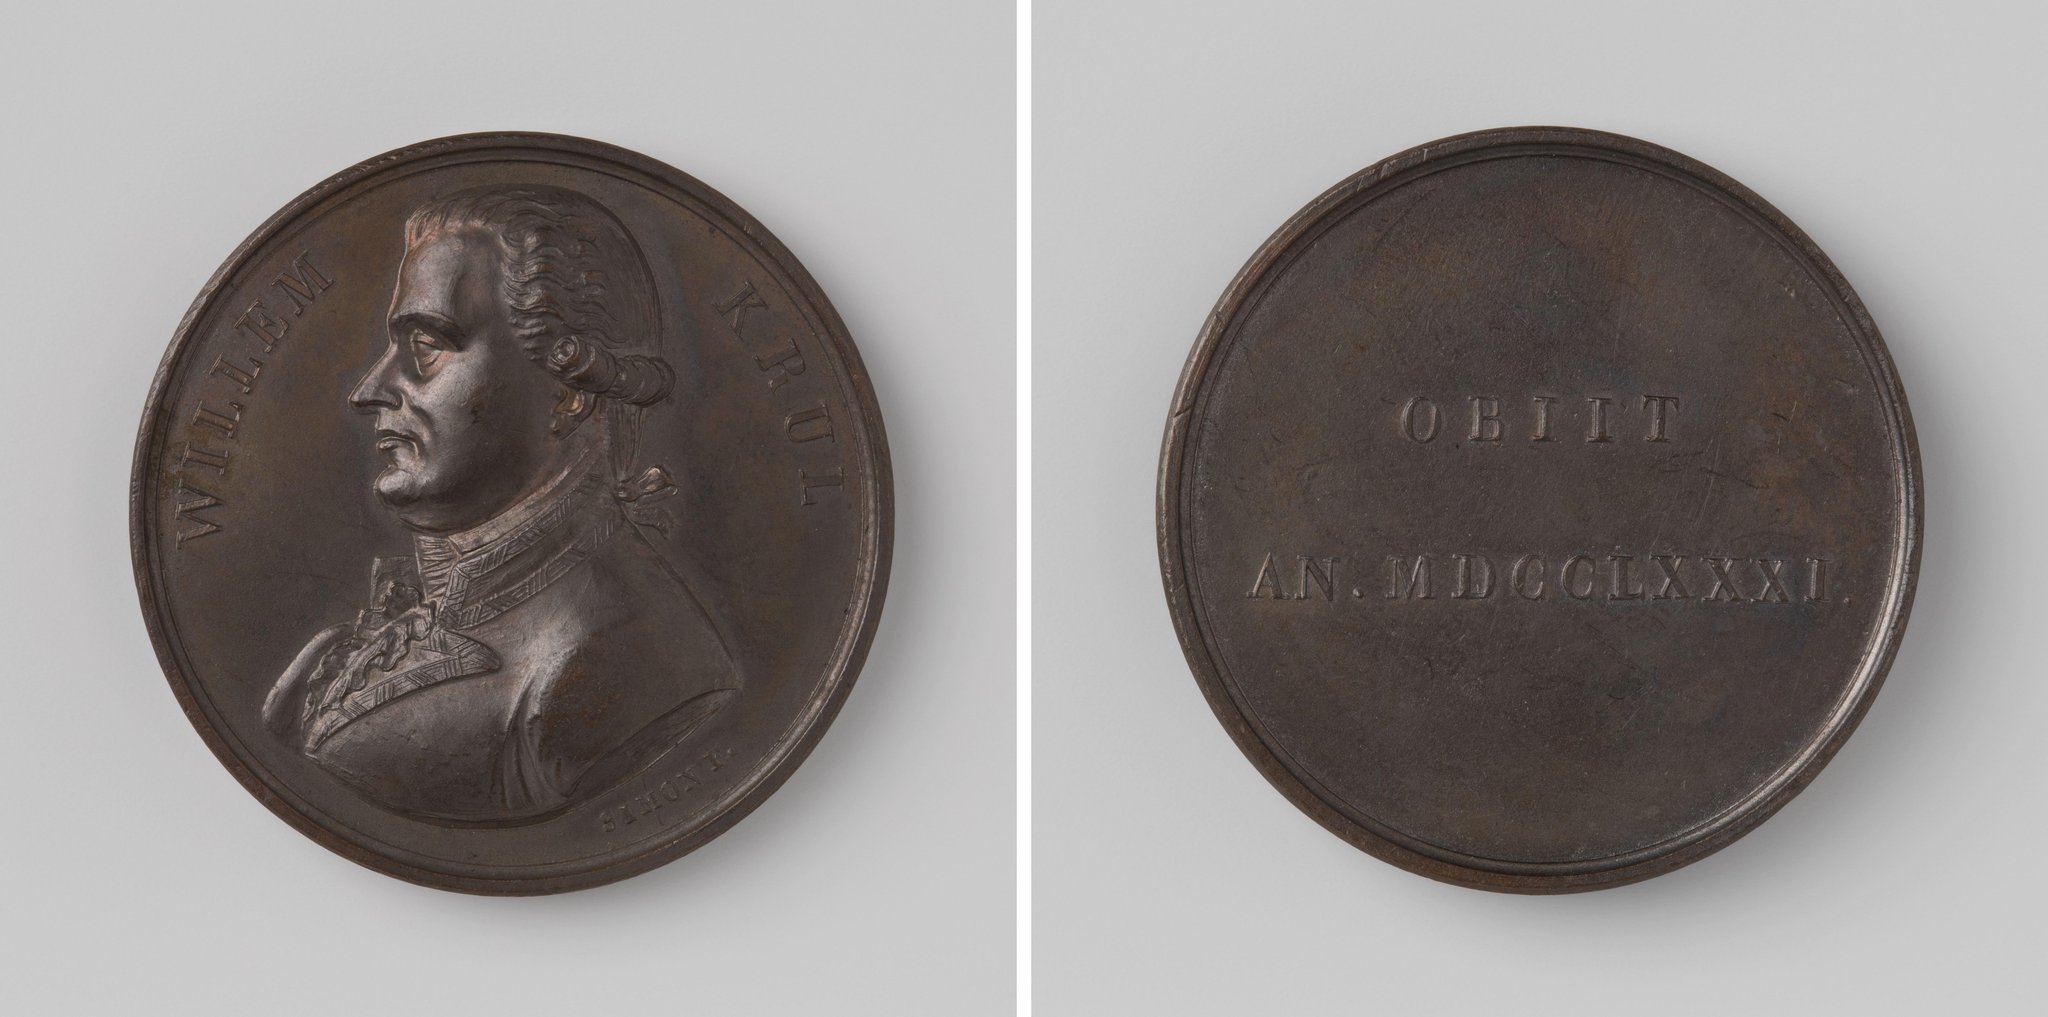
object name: history medal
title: Willem Crul, schout-bij-nacht van Holland en West-Friesland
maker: jean henri simon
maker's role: medailleur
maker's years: 1752-1834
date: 1816-1834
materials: bronze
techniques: striking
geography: brussels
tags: haarlem, fourth anglo-dutch war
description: Bronzen penning. Voorzijde: borststuk man binnen omschrift. Keerzijde: opschrift